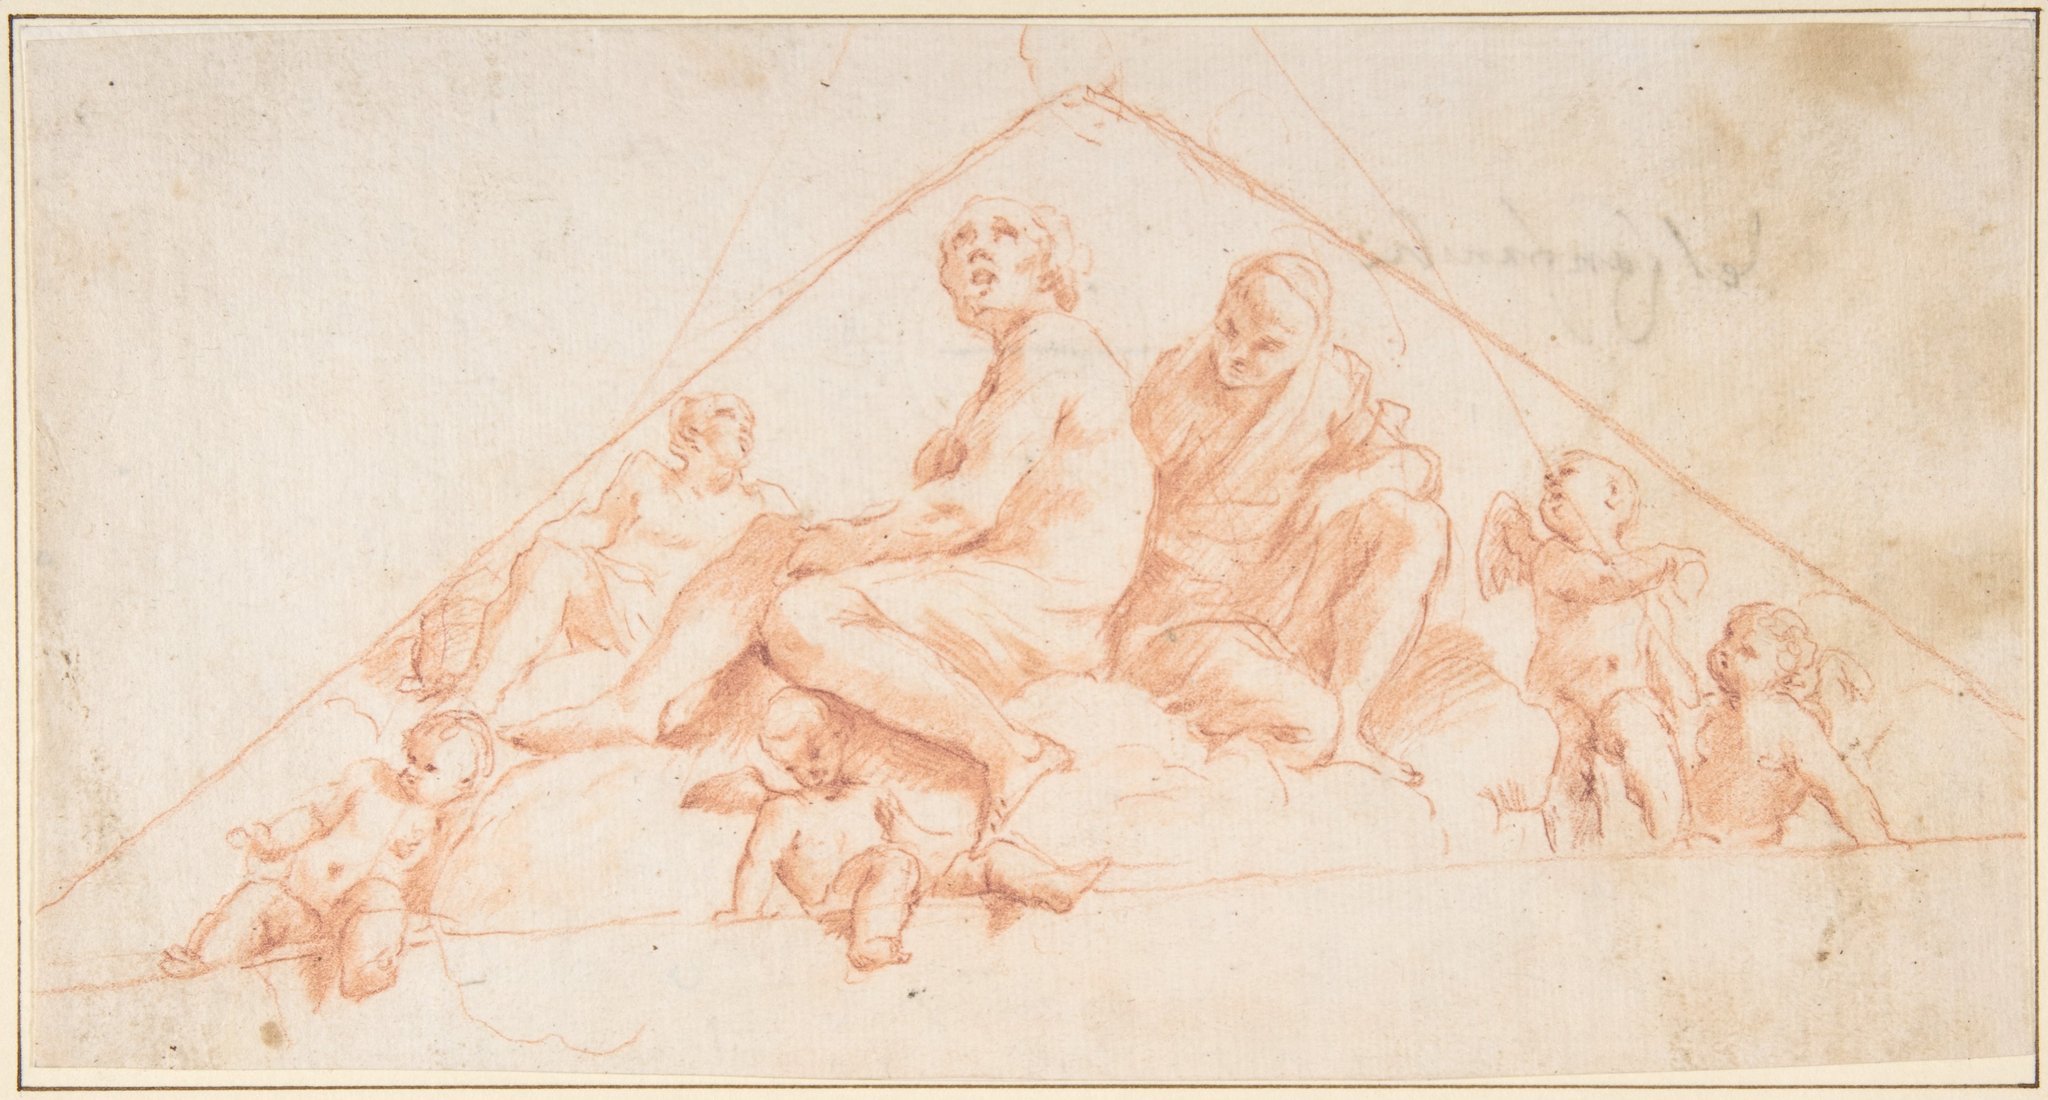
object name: drawing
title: Seated Apostles and Putti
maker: giovanni lanfranco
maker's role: artist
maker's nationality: italian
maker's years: 1582-1647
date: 1637-1638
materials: chalk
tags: sibyl,angels,apostles